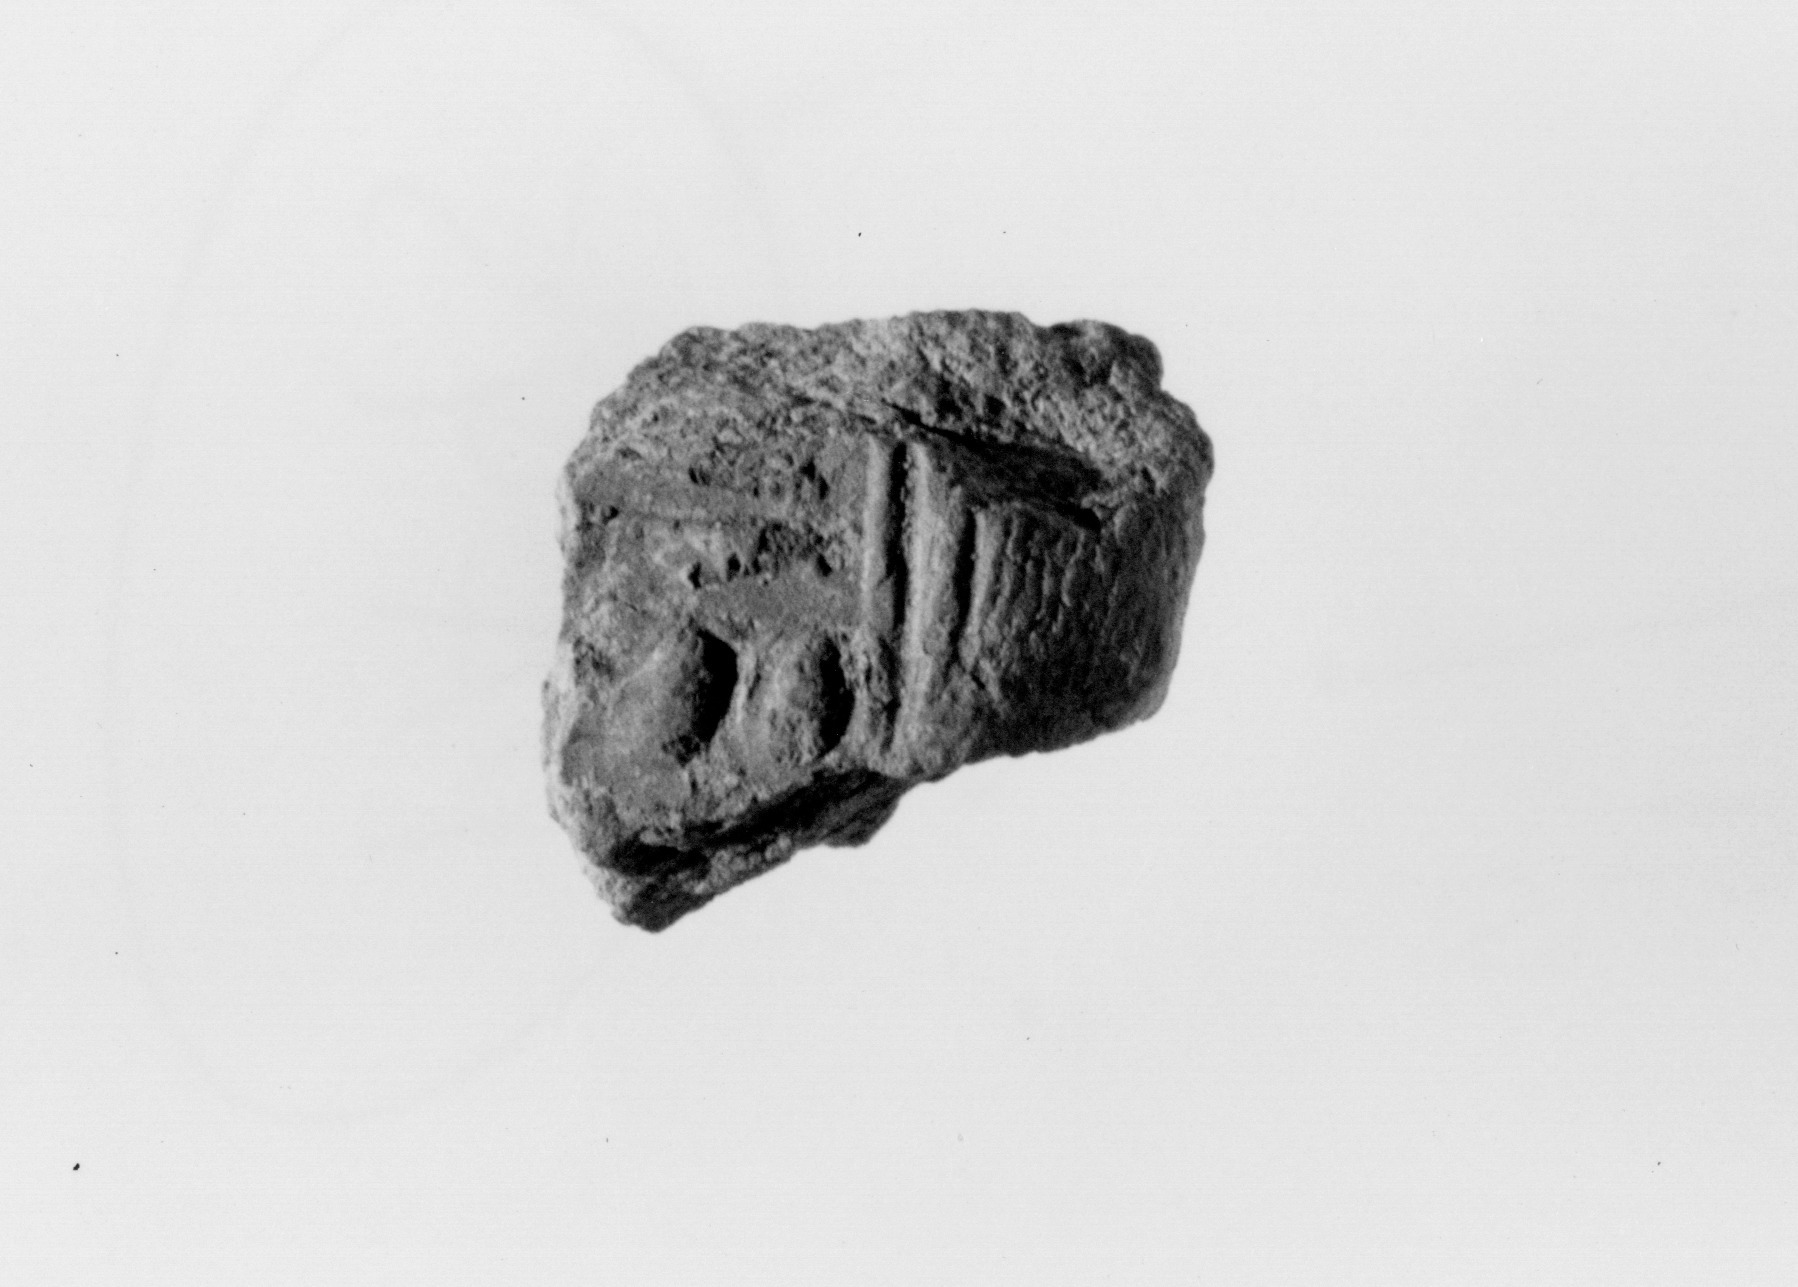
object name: sealing, nebmaatre, amenhotep iii,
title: Document Sealing With the Throne Name of Amenhotep III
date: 1390-1352 BCE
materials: mud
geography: egypt